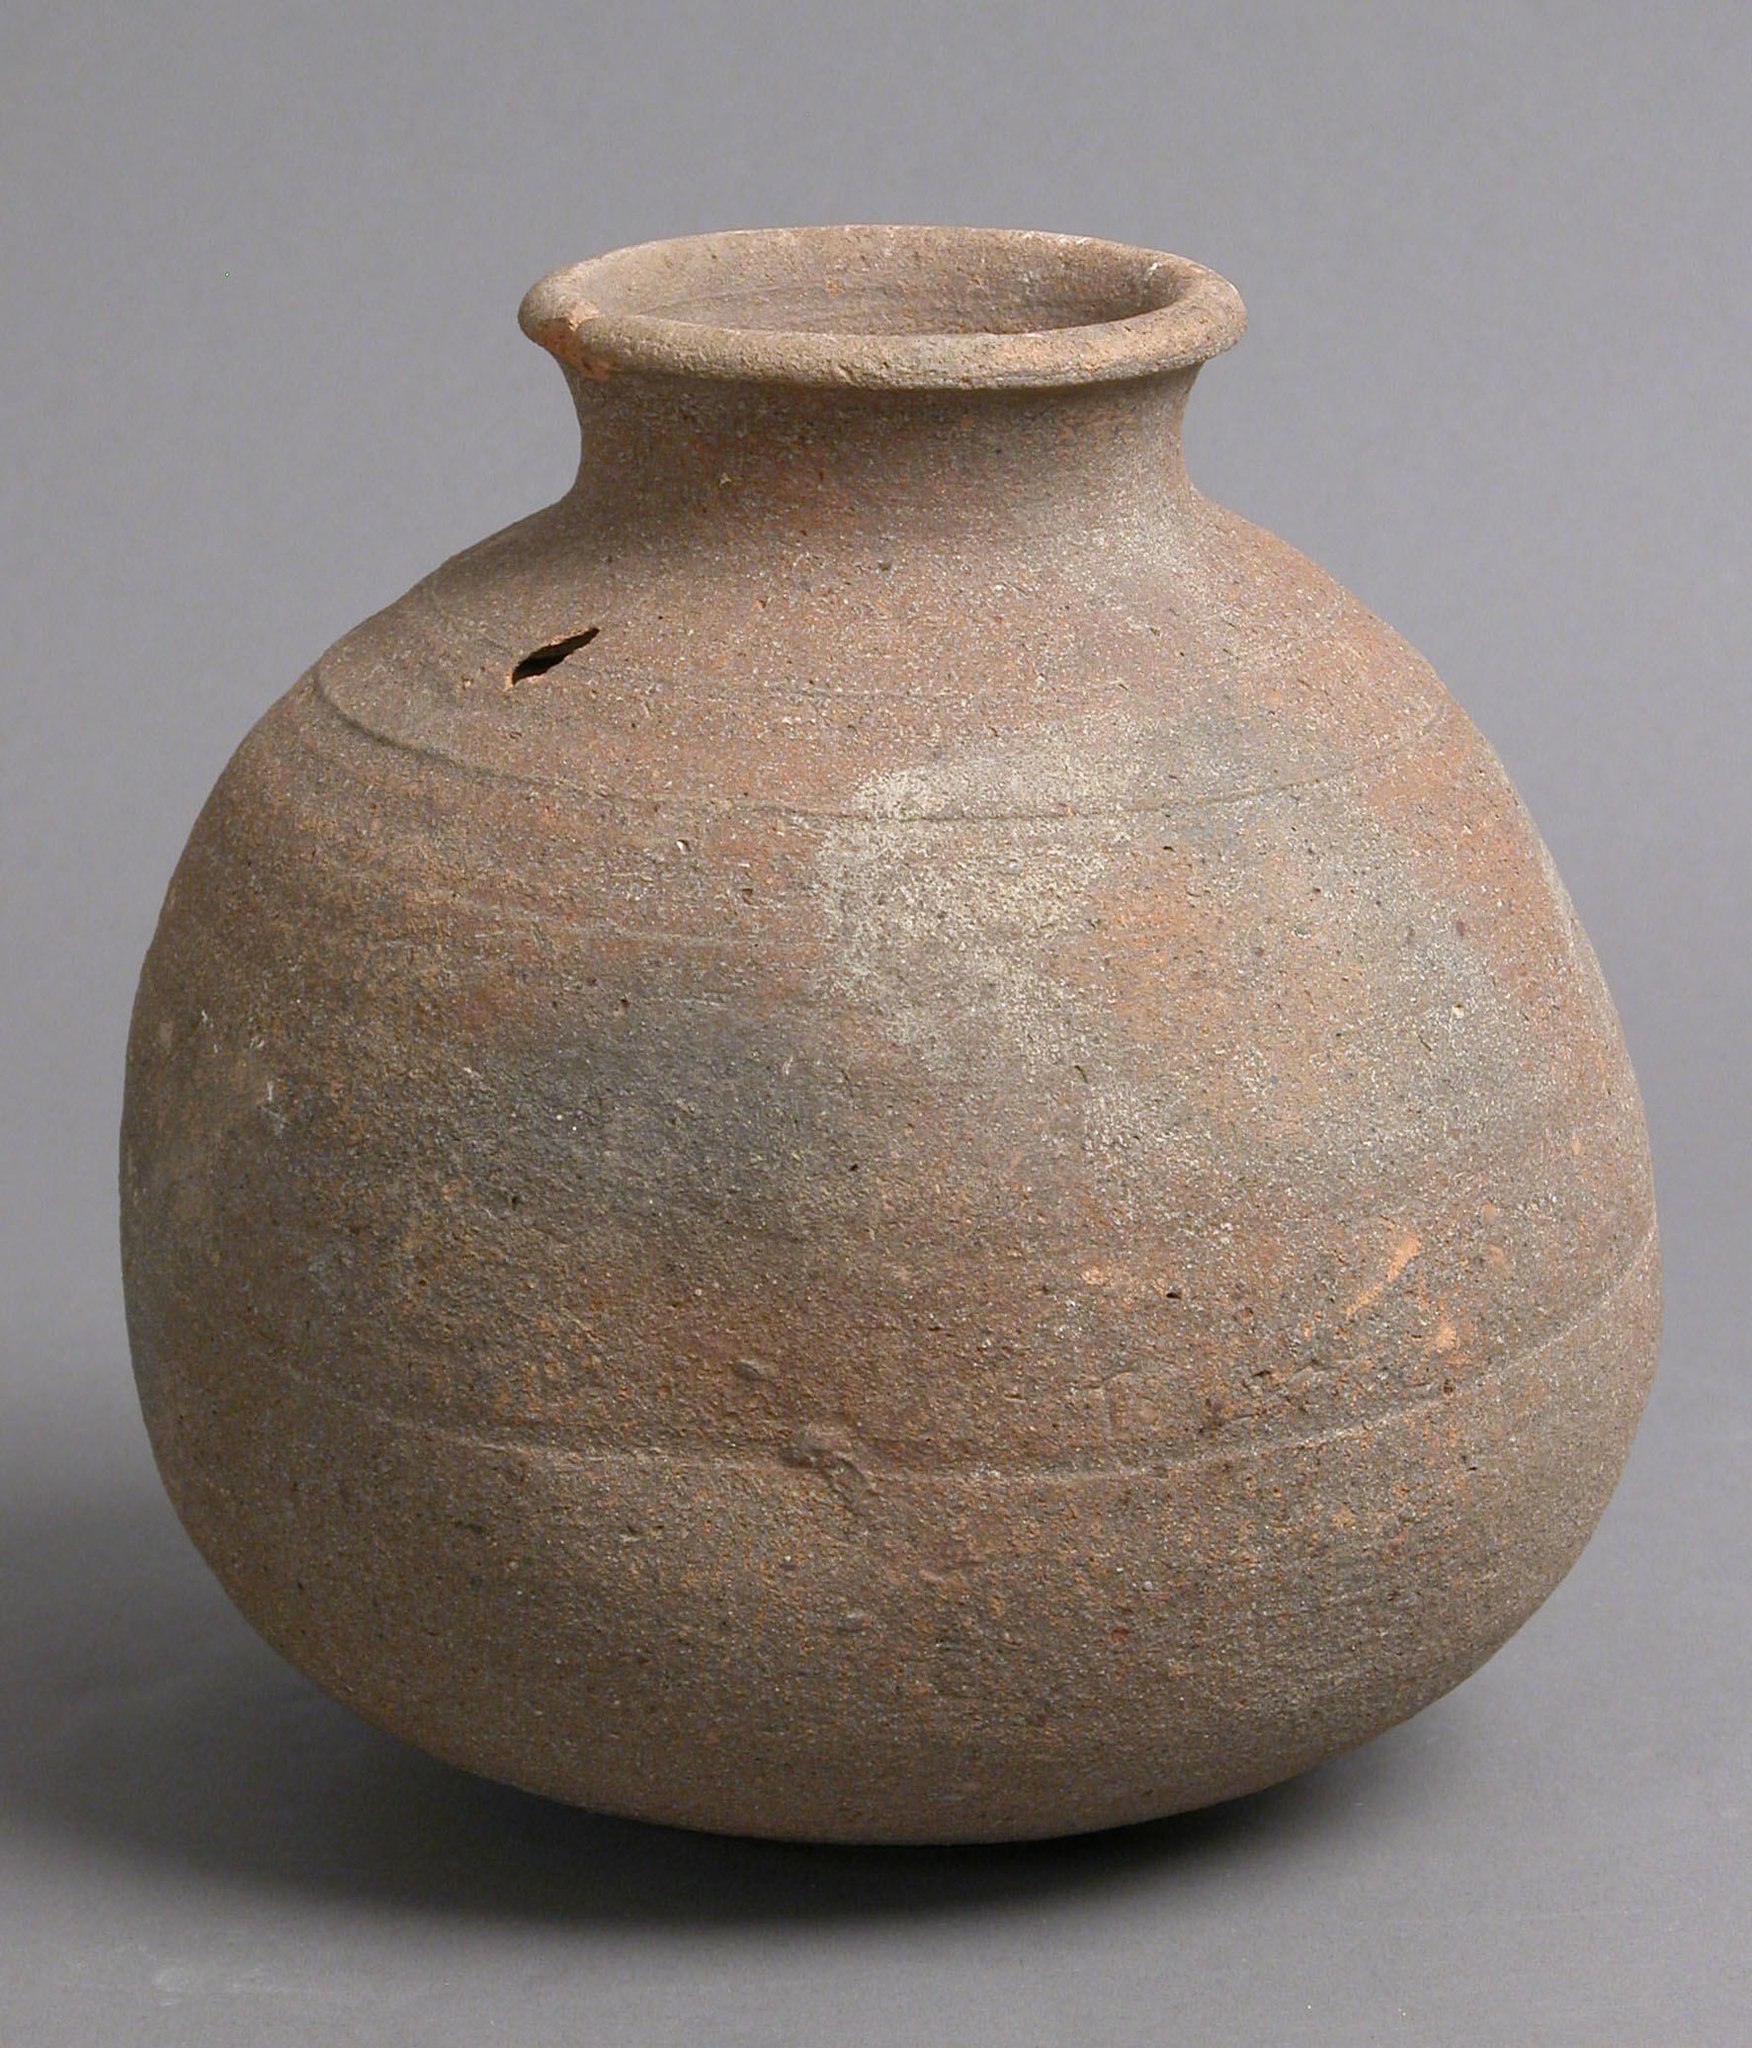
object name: pot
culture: coptic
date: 301-700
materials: earthenware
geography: egypt